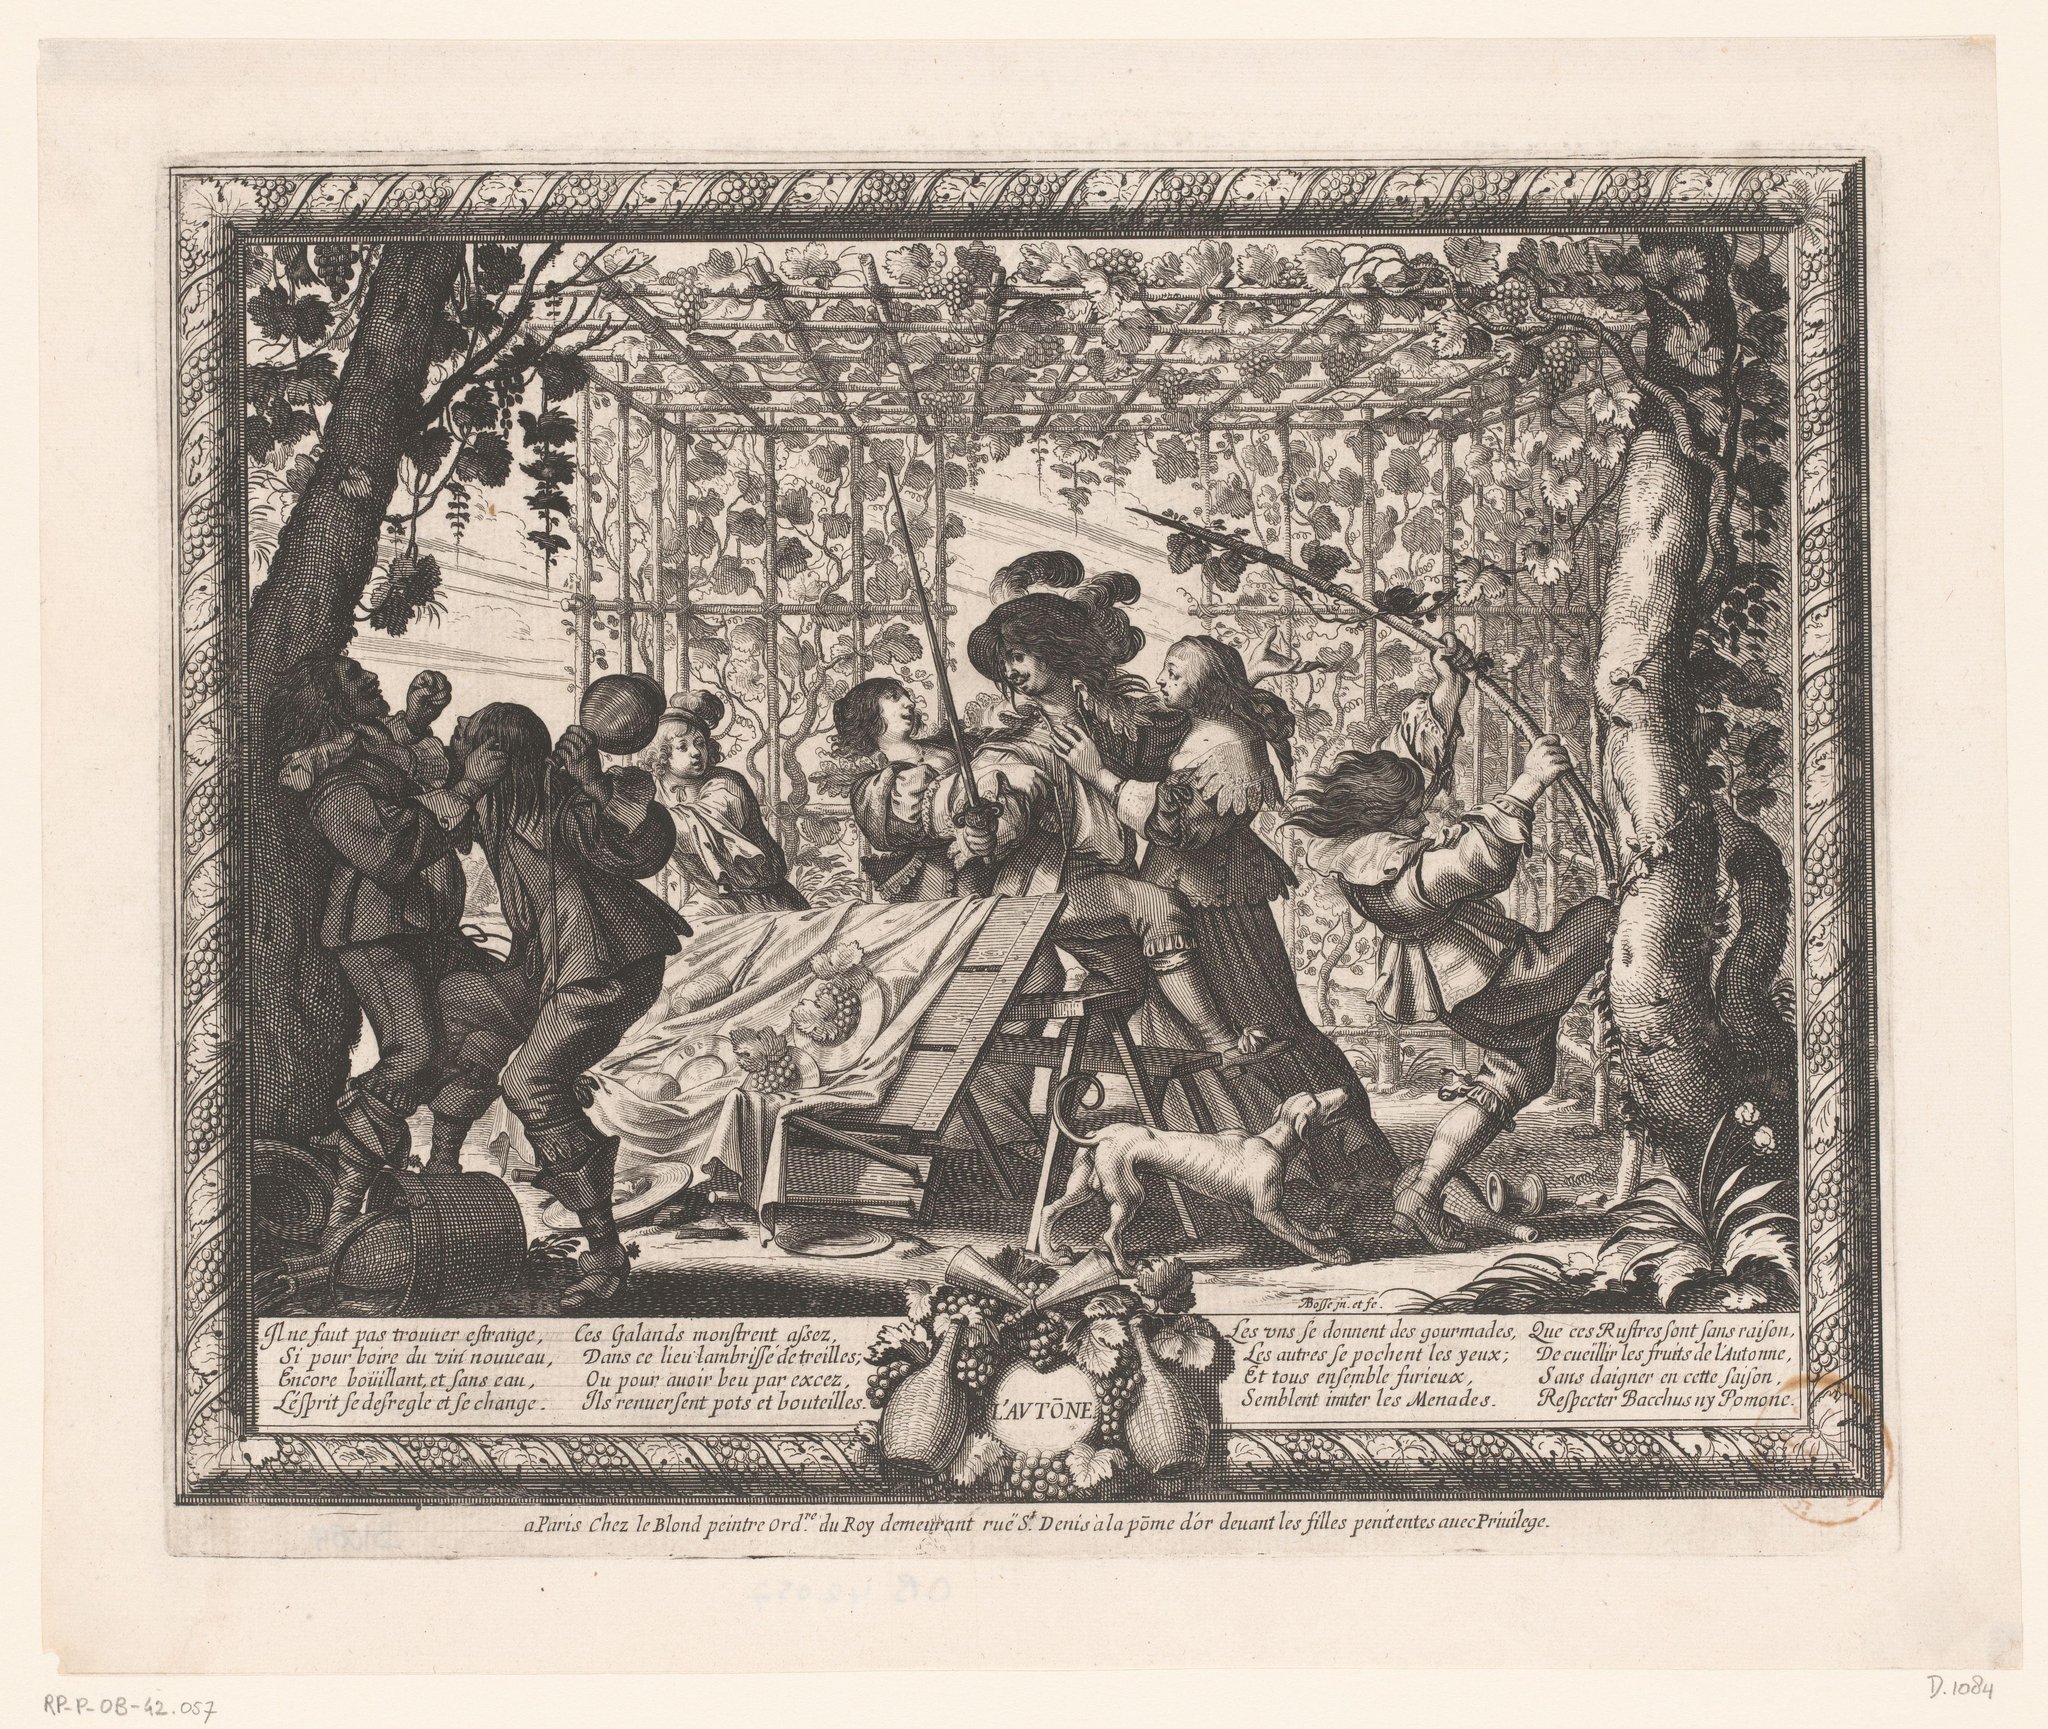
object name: print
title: De vier seizoenen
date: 1636-1637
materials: paper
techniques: engraving, etching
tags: vine, year divided into four seasons, bottle of wine, autumn, fall, 'autumnus'; 'autunno' (ripa), viticulture, wine-growing; vintage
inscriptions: collector's mark: Lugt 240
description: Maakt deel uit van een serie van vier platen met als onderwerp de vier seizoenen.